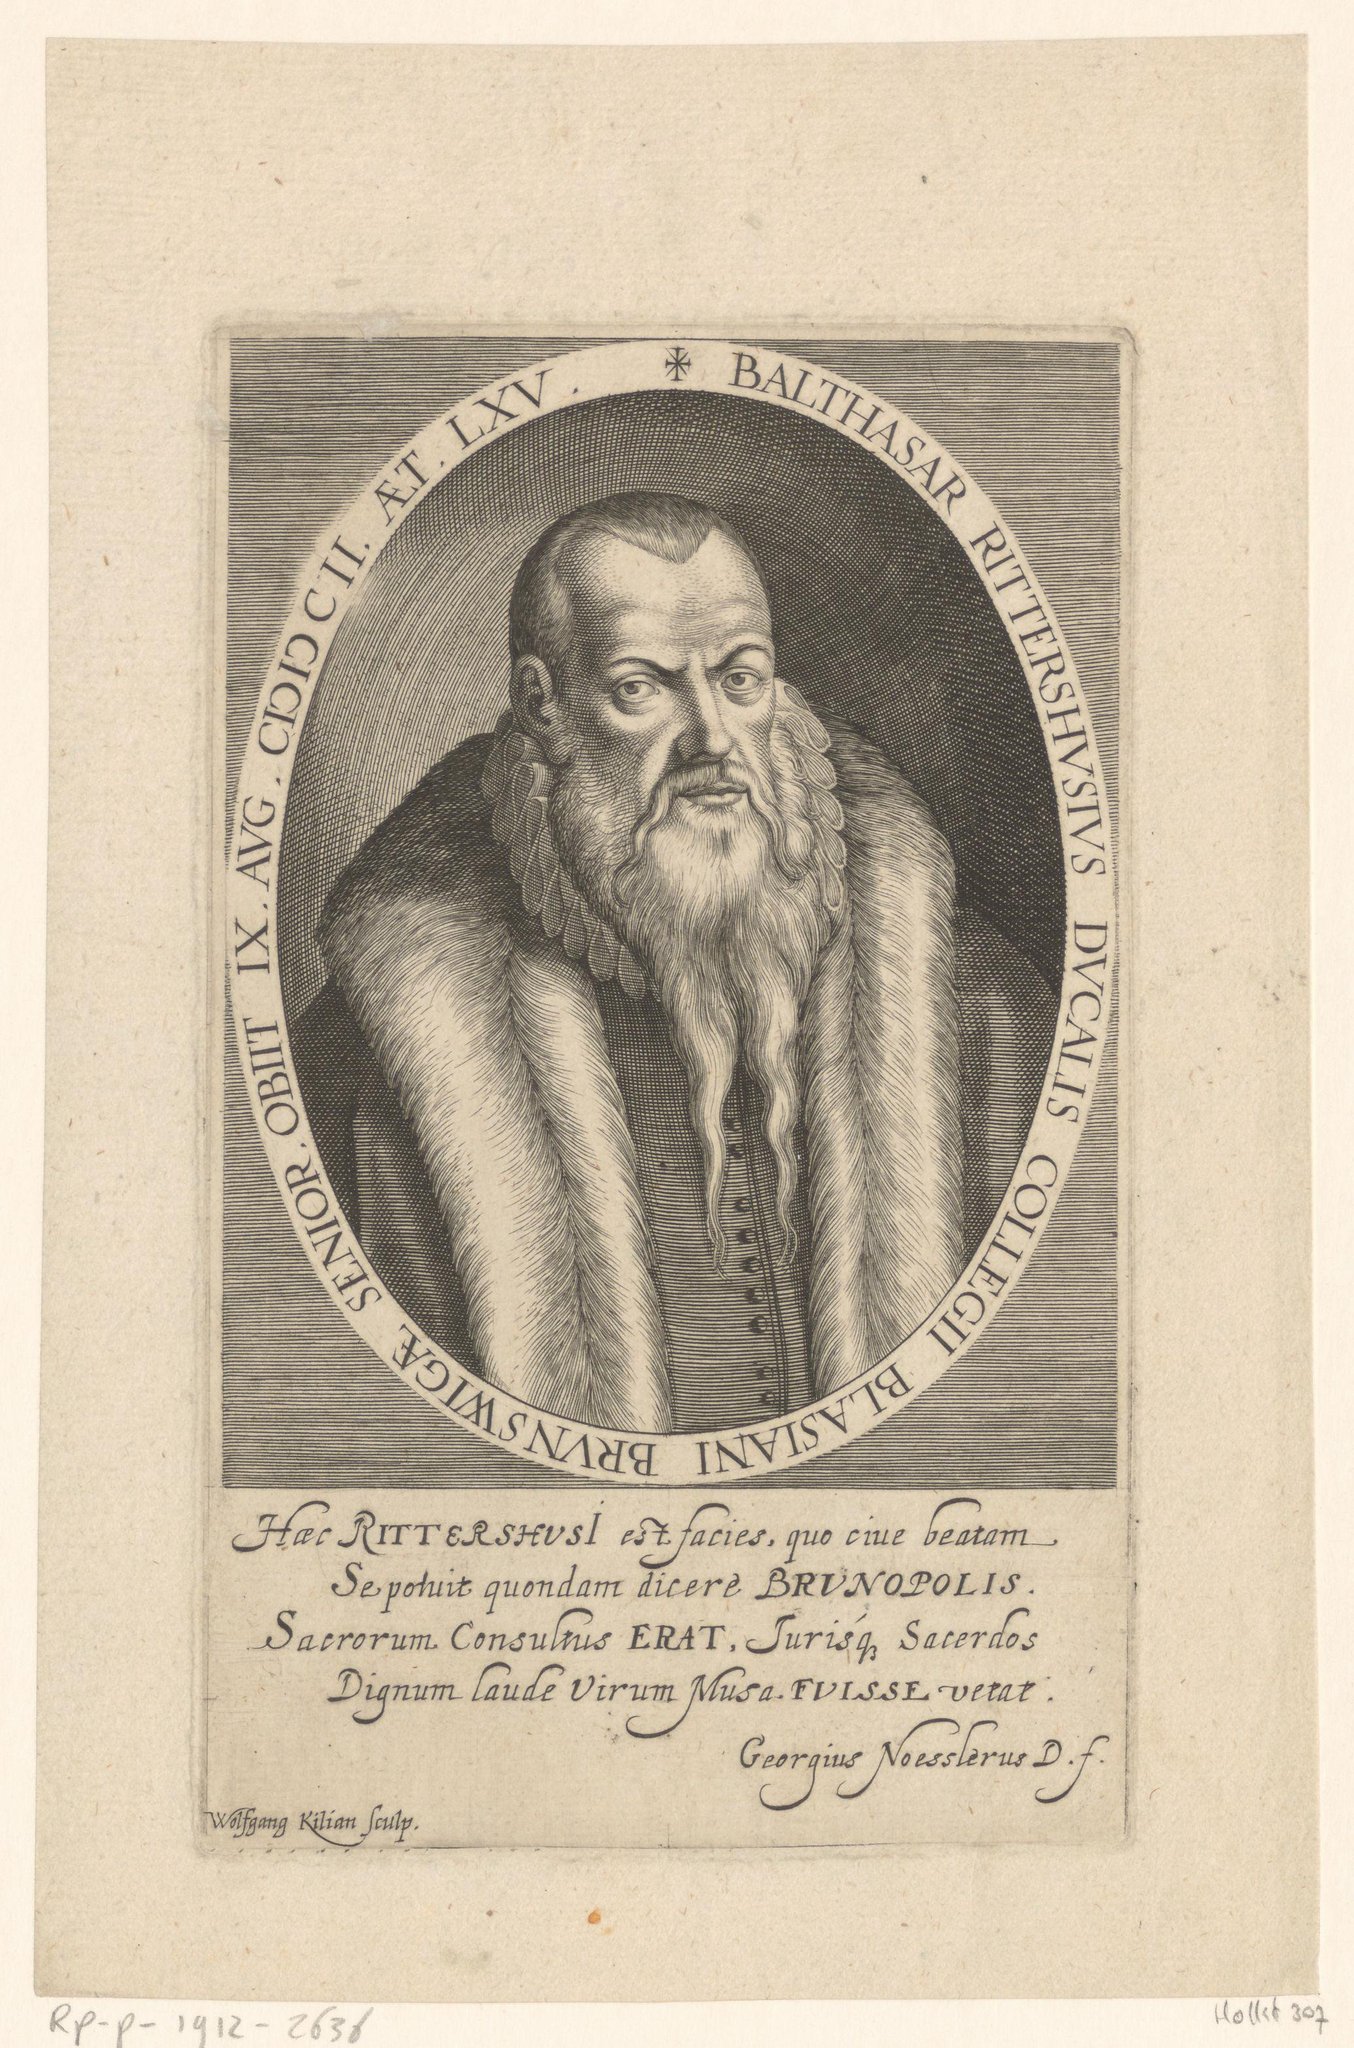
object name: print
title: Portret van Balthasar Rittershausen op 65-jarige leeftijd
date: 1602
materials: paper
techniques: engraving, etching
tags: theologian, historical persons, lawyer, attorney at law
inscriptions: collector's mark: Lugt 2228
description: Tekst in het Latijn in de omlijsting en in de marge.